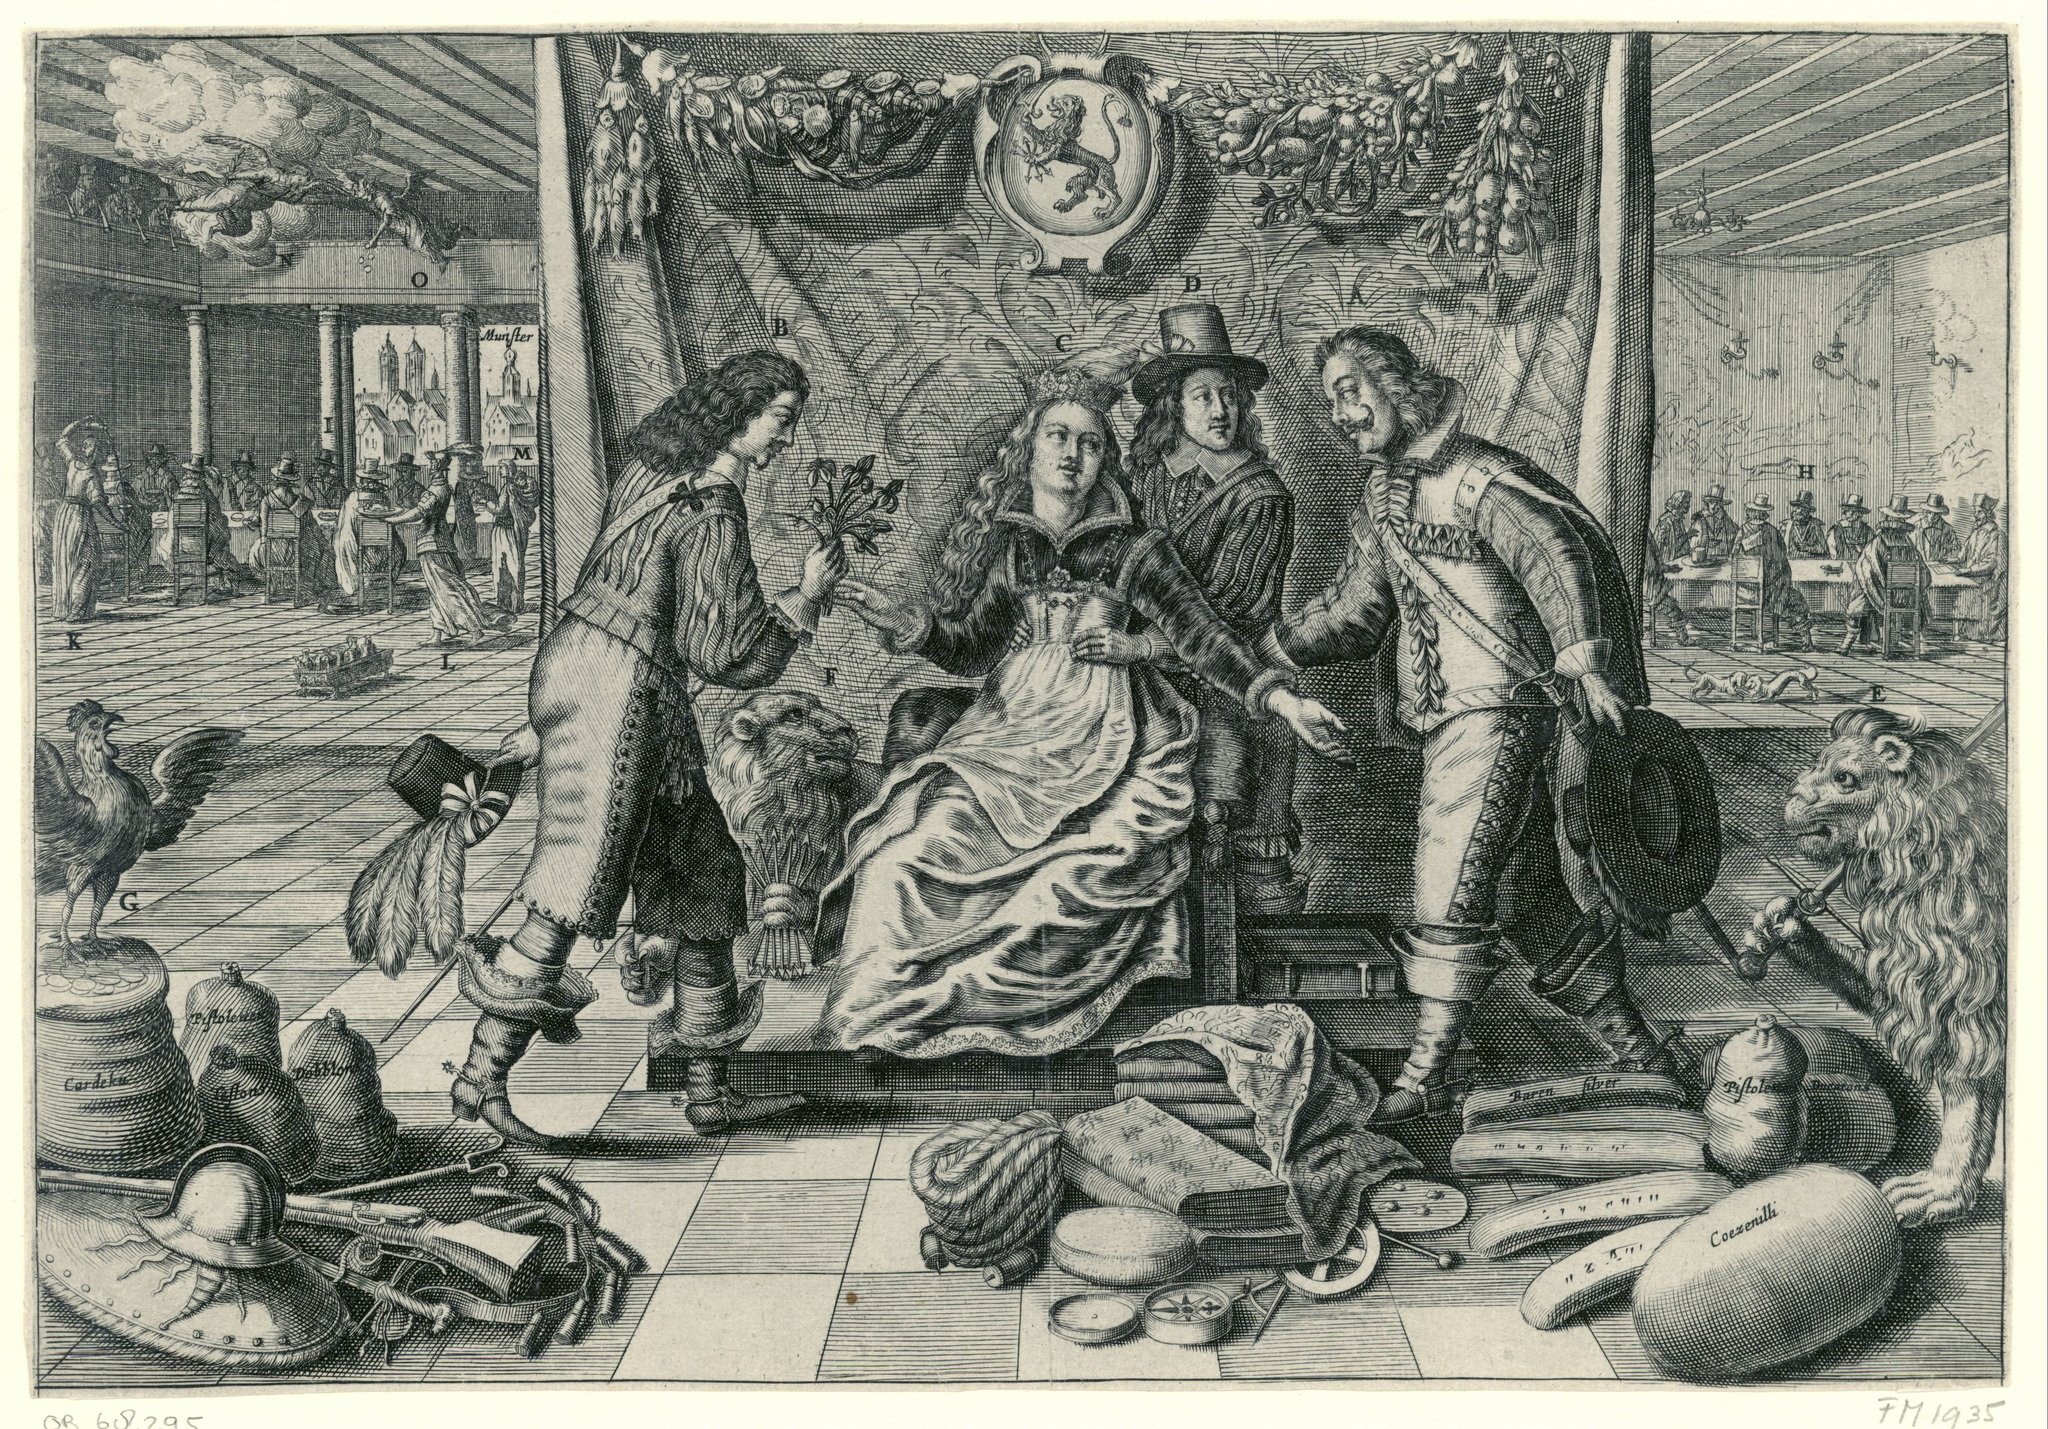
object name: print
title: Vrijage om de Hollandse Bruid, ca. 1647-1648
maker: crispijn van de passe (ii)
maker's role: draughtsman, print maker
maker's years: 1594-1670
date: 1647-1648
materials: paper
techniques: engraving, etching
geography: northern netherlands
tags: peace negotiations, presents offered to the beloved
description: Allegorische voorstelling waarin de Hollandse Bruid het hof wordt gemaakt door een Spanjaard en een Fransman, ca. 1647-1648. Allegorie op de vredesonderhandelingen met Spanje, tegen de zin van Frankrijk. Links op de achtergrond de vredesonderhandelingen te Munster. Elementen in de voorstelling zijn met letters aangeduid; de legenda ontbreekt echter. De landen worden behalve door hun personificaties ook door symbolische dieren vertegenwoordigd: de Franse haan, de Nederlandse leeuw en de Spaanse leeuw.